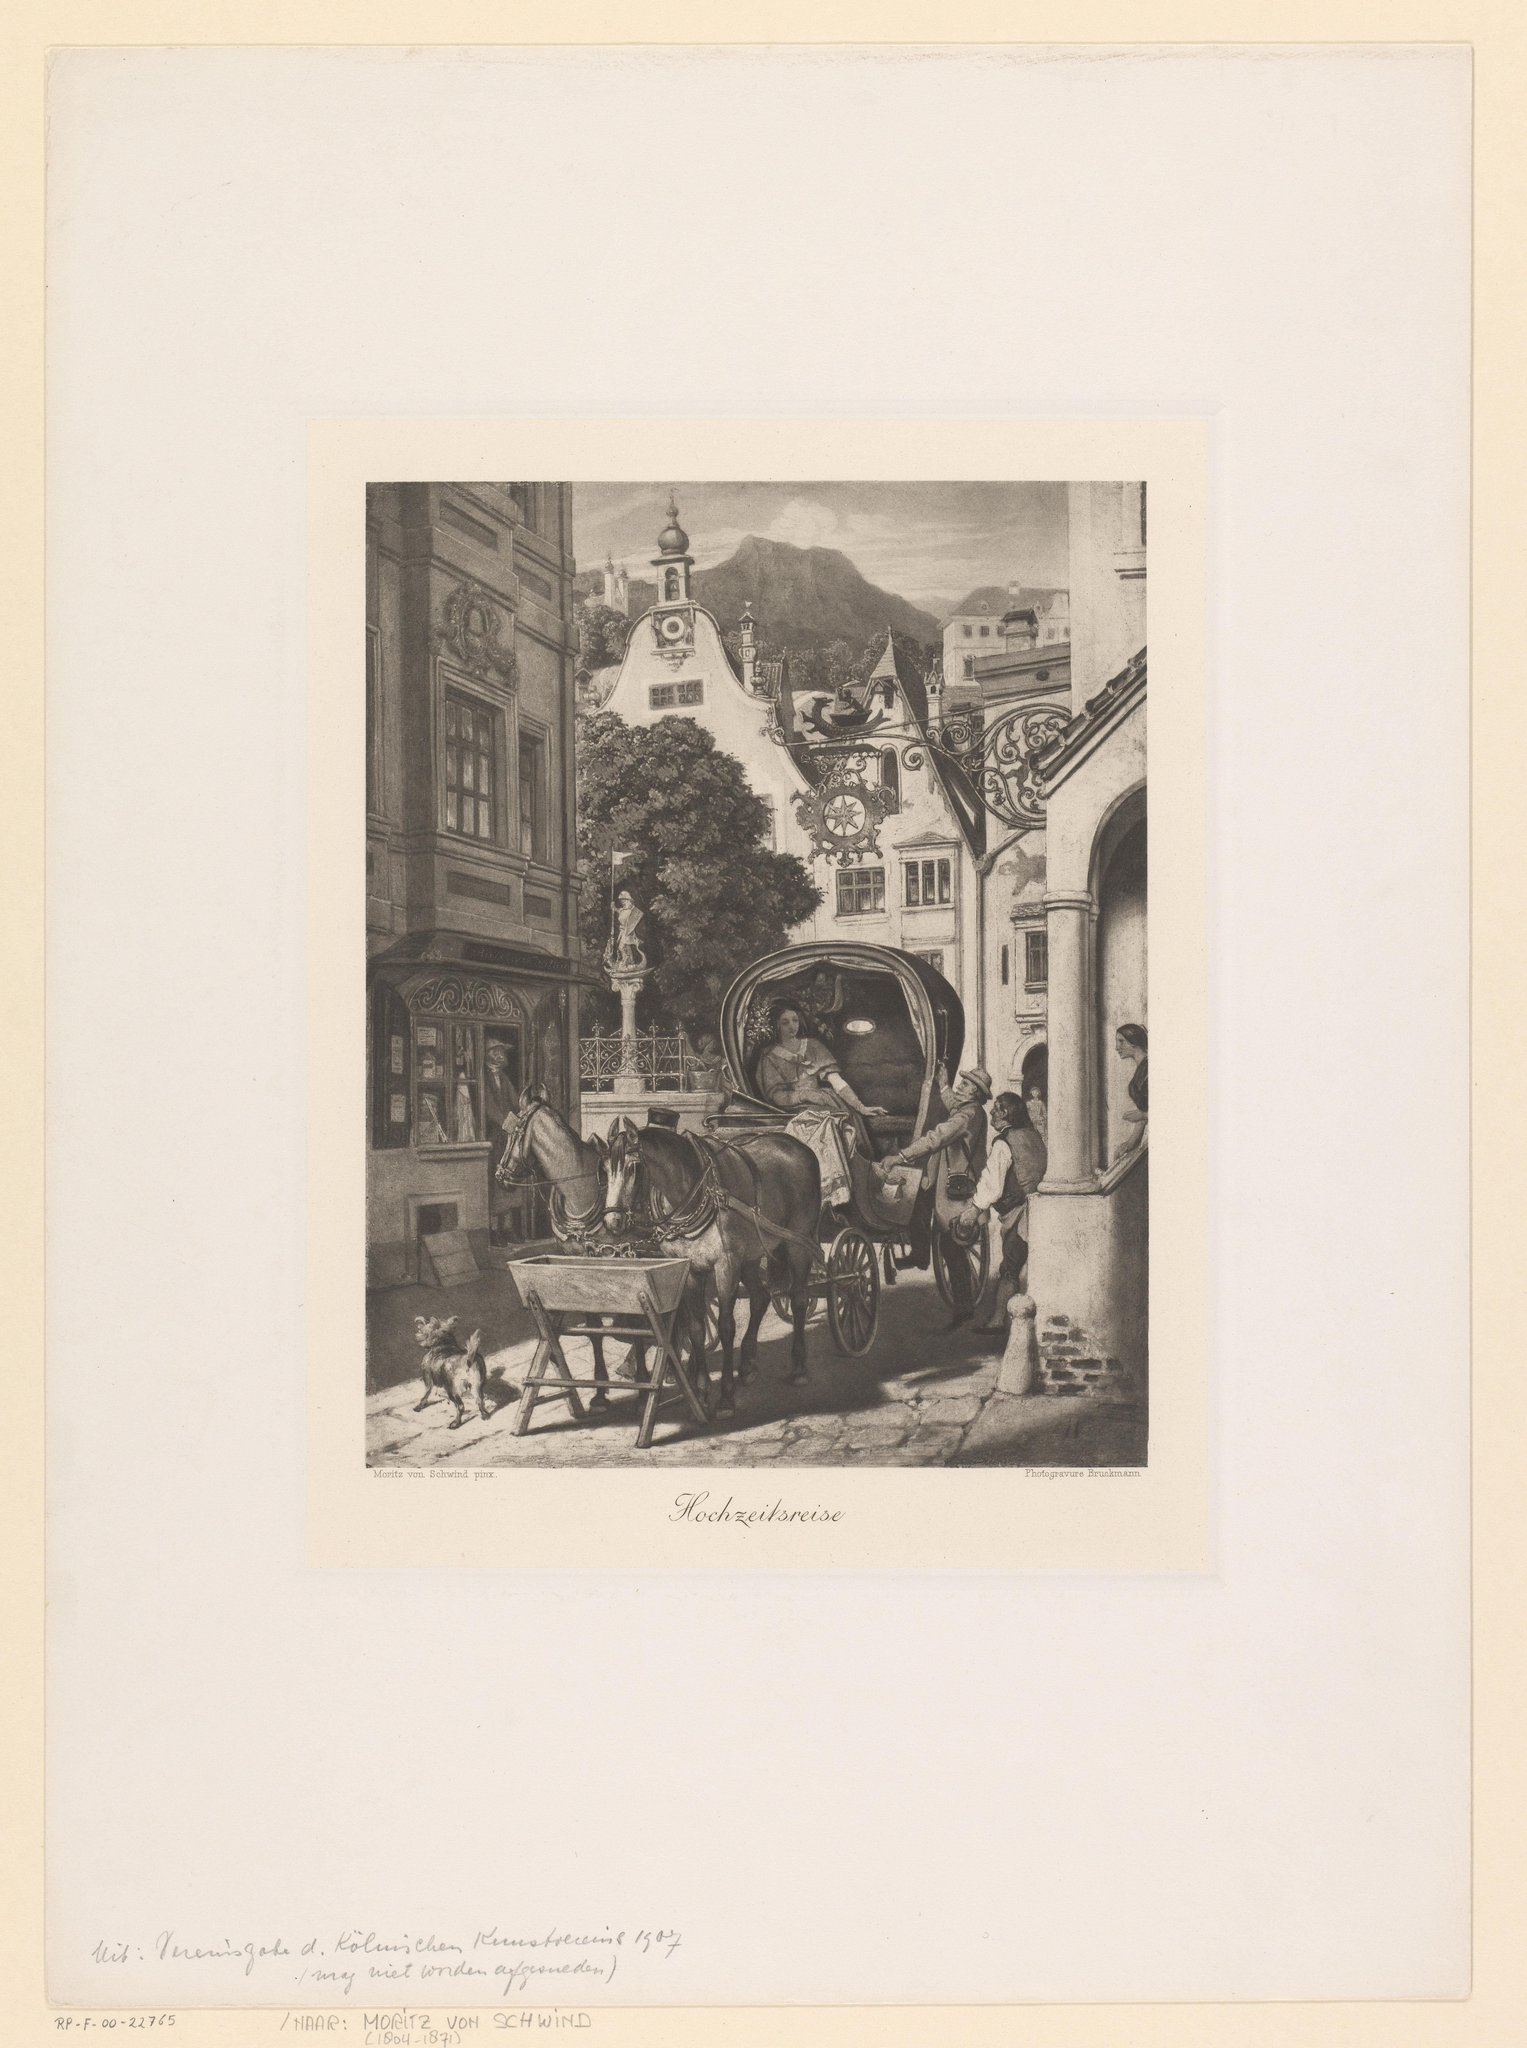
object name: photomechanical print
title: Hochzeitsreise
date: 1907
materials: cardboard, paper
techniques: photoaquatint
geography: munich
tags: departure (for honeymoon), four-wheeled vehicle drawn by two animals, germany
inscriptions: collector's mark: Lugt 2166